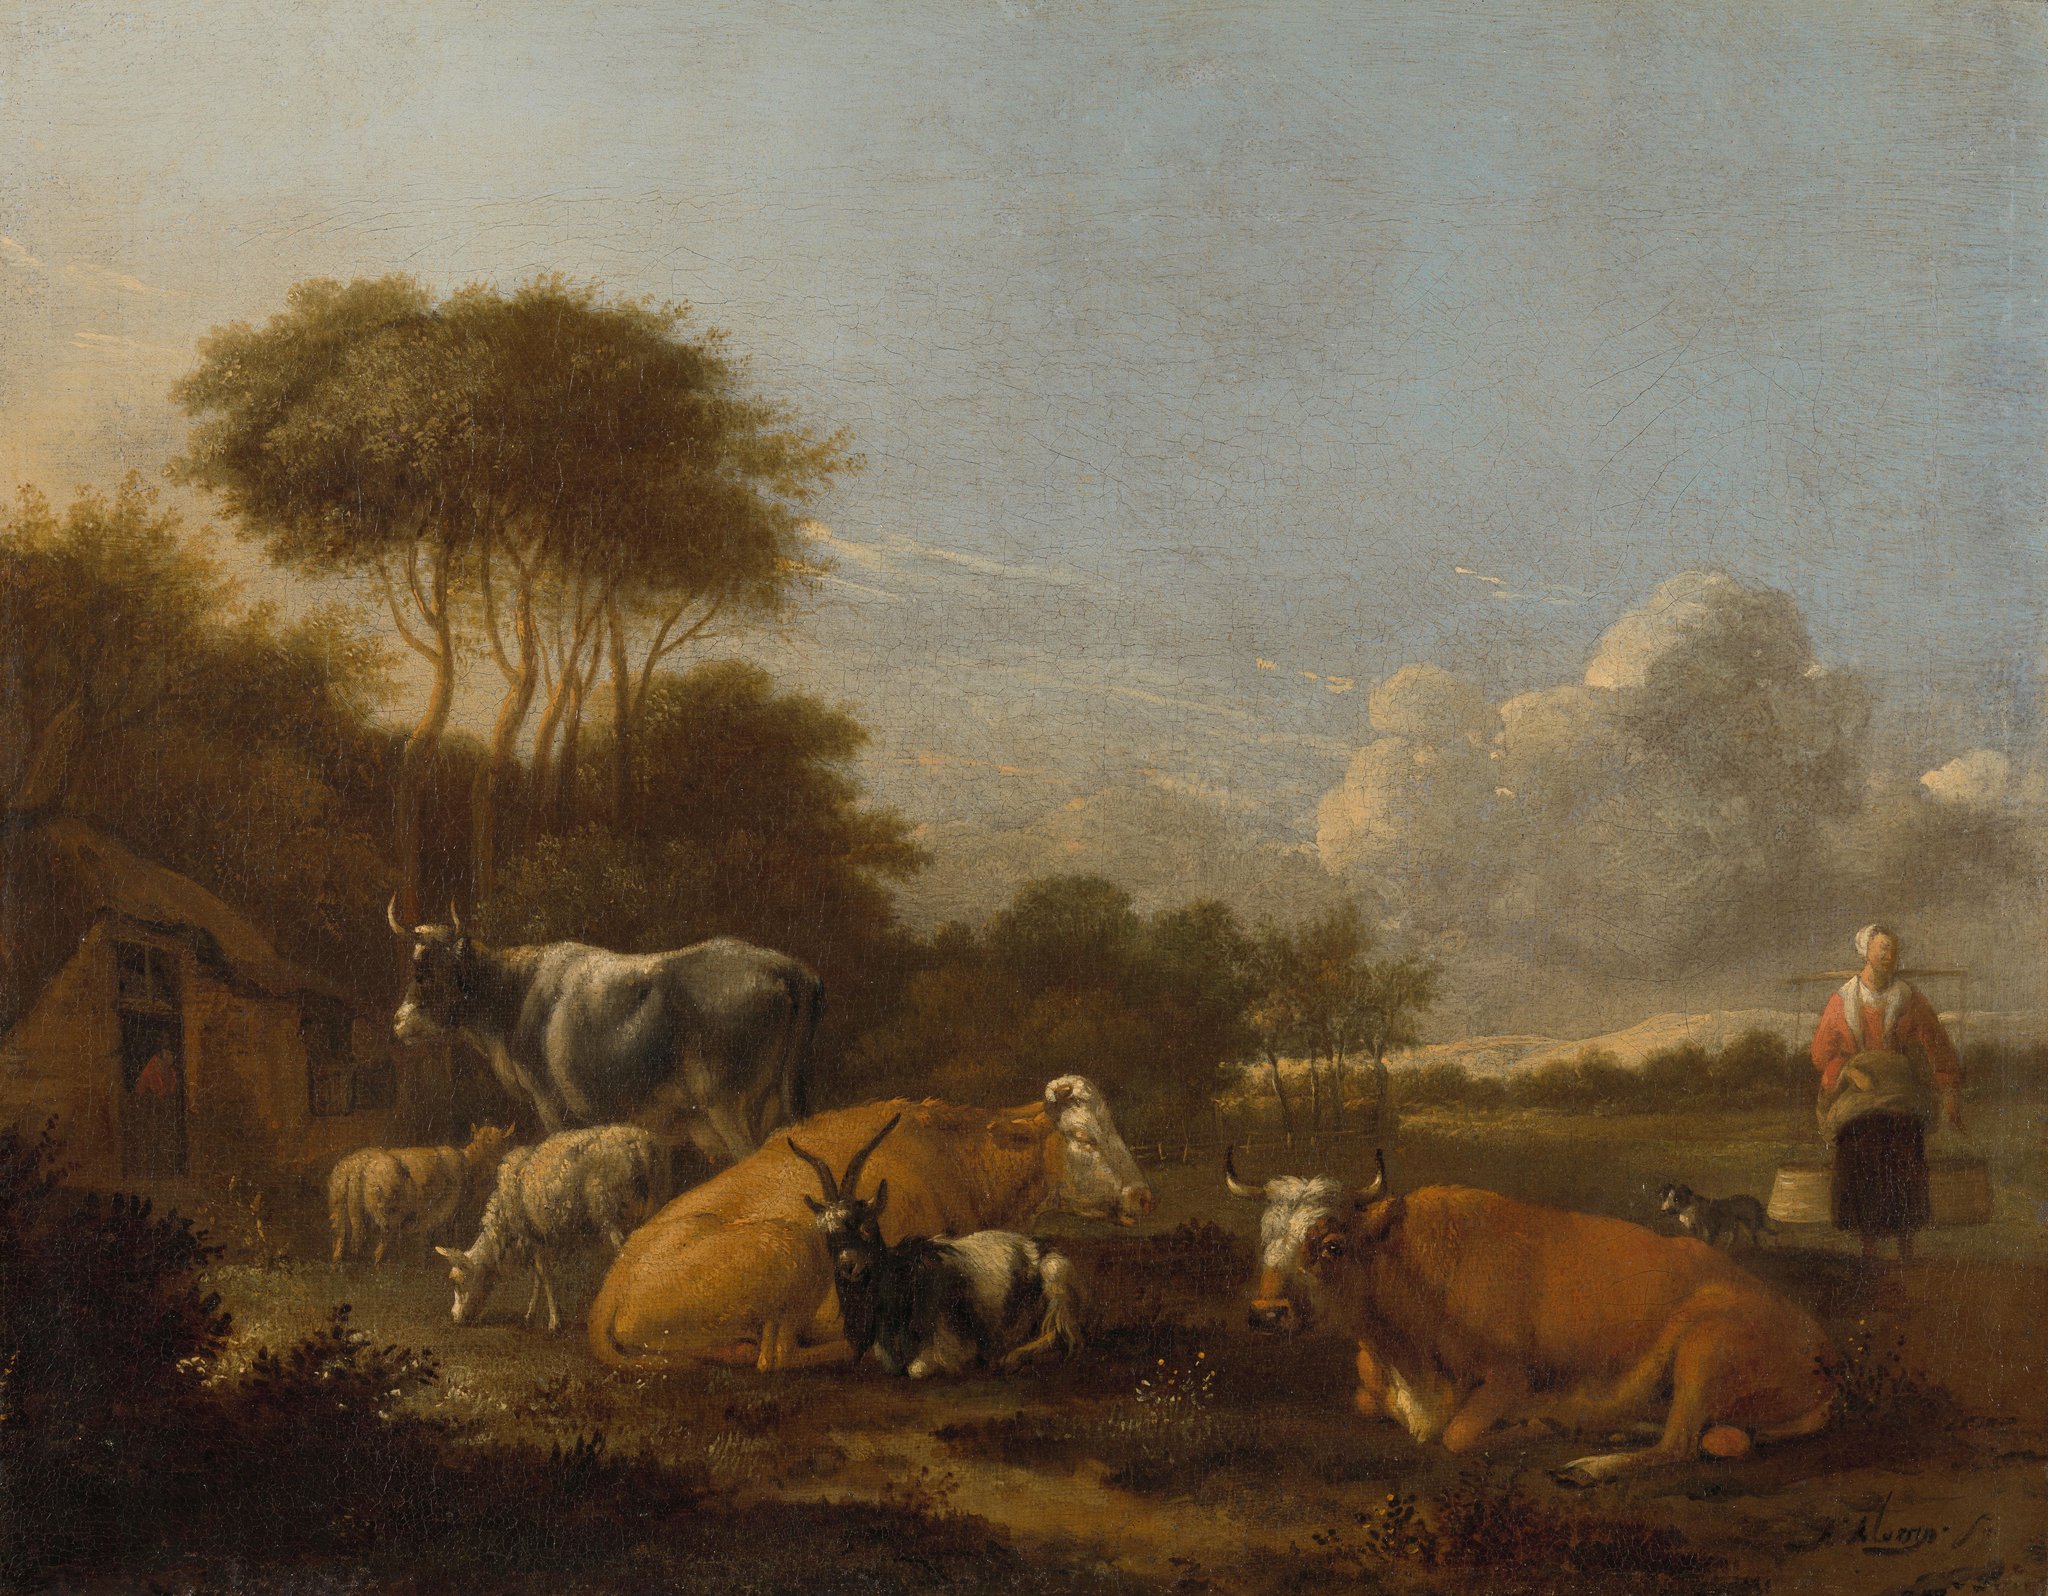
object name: painting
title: Landscape with Cattle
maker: albert jansz klomp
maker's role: draughtsman, painter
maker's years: 1618-1688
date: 1665-1688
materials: canvas, oil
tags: cattle, carrying something with yoke, milkmaid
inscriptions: signature, lower right: ‘A. Klomp f.’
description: Landschap met vee. Op de voorgrond liggen koeien, een geit en enkele schapen. Rechts een boerin met een juk met emmers op de schouders, links een boerderij onder bomen. Pendant van SK-C-161.